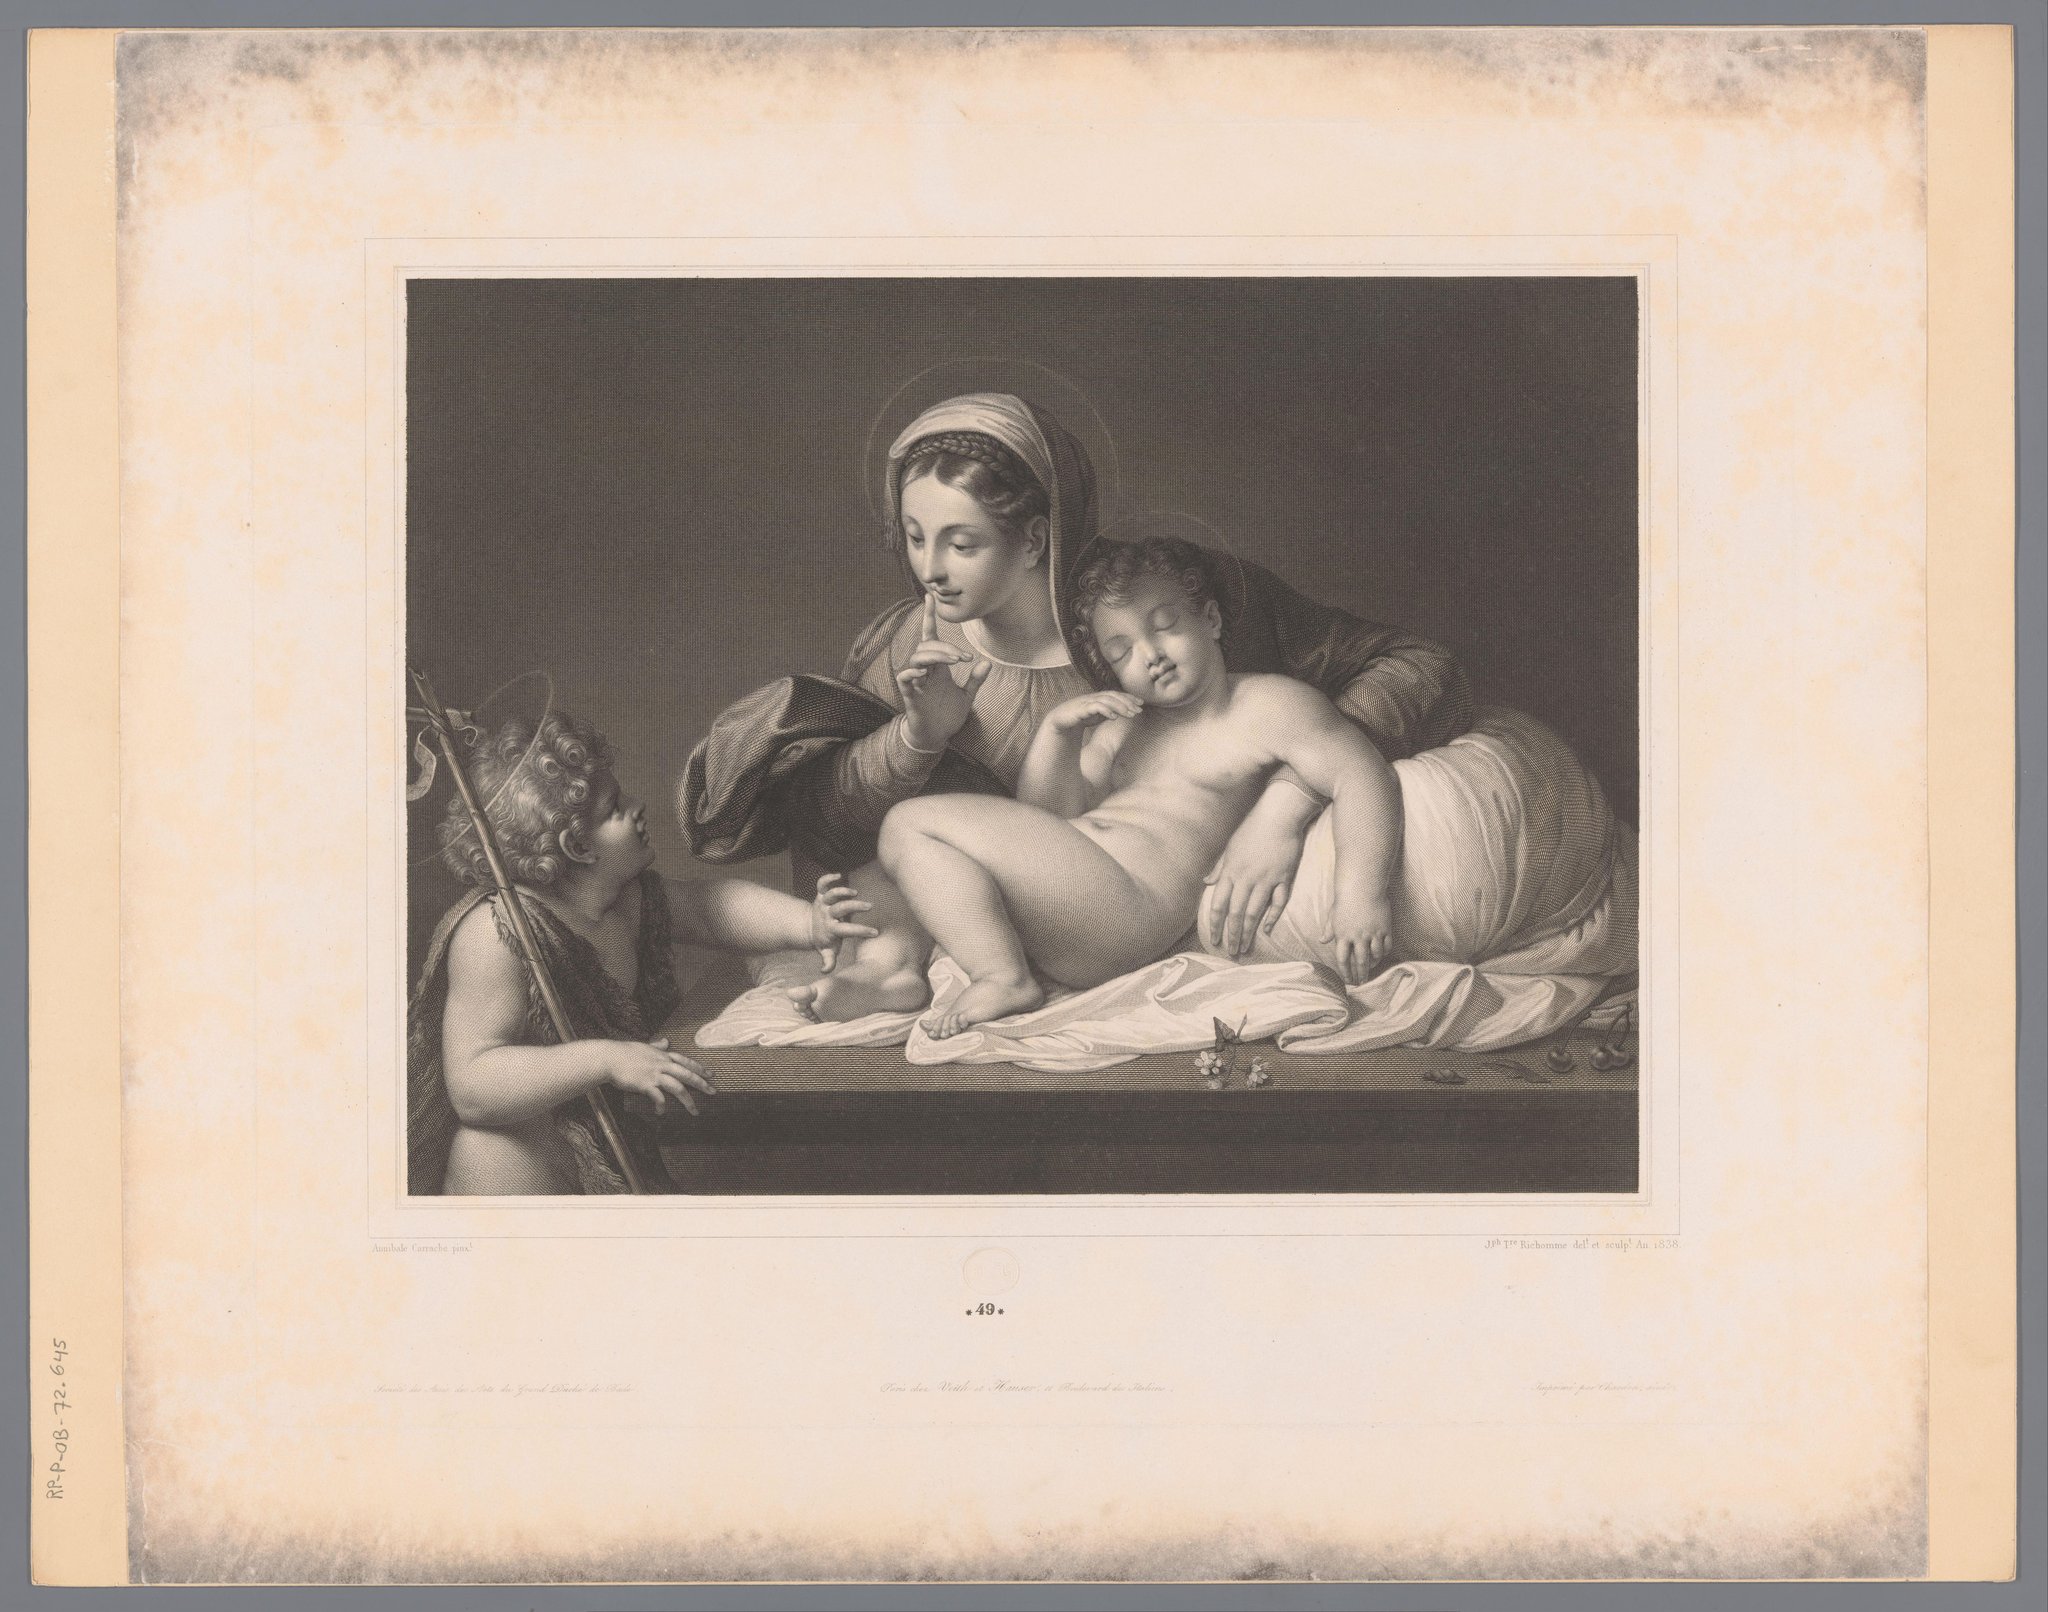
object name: print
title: Maria met slapende Christus maant Johannes de Doper tot stilte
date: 1838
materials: paper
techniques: engraving, etching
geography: paris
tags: christ-child sleeping ~ madonna-representations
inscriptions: collector's mark: Lugt 12, check stamp: Lugt 4211